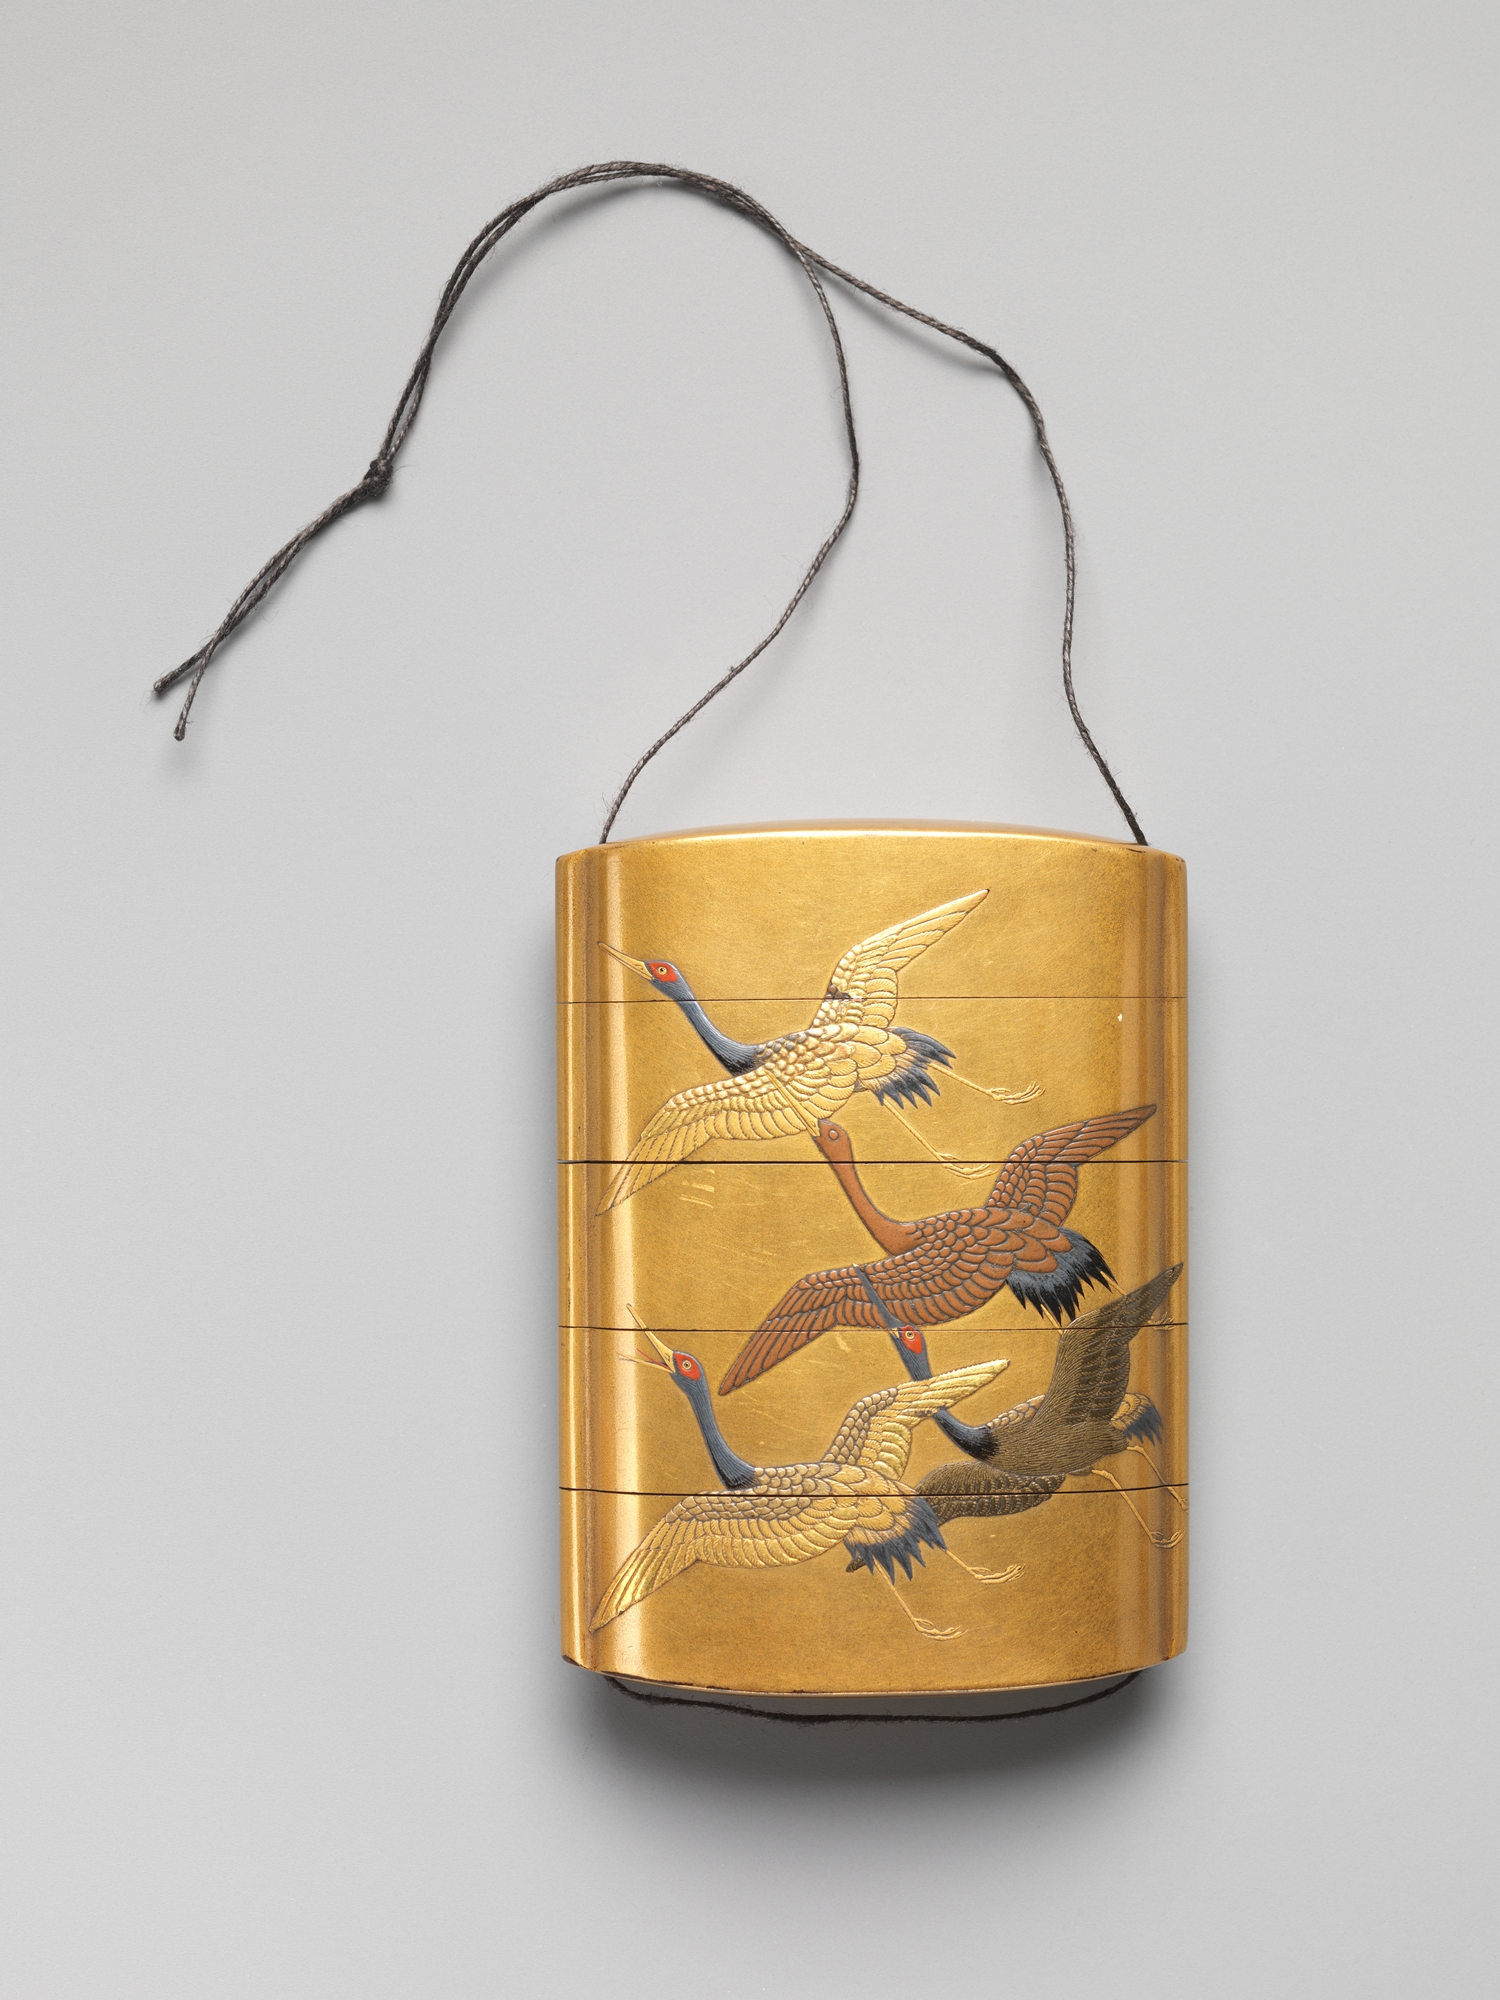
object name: inrō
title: Case (Inrō) with Design of Seven Cranes in Flight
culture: japanese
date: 1701-1900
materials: gold, gold foil, lacquer, silver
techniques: fundame, hiramakie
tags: cranes